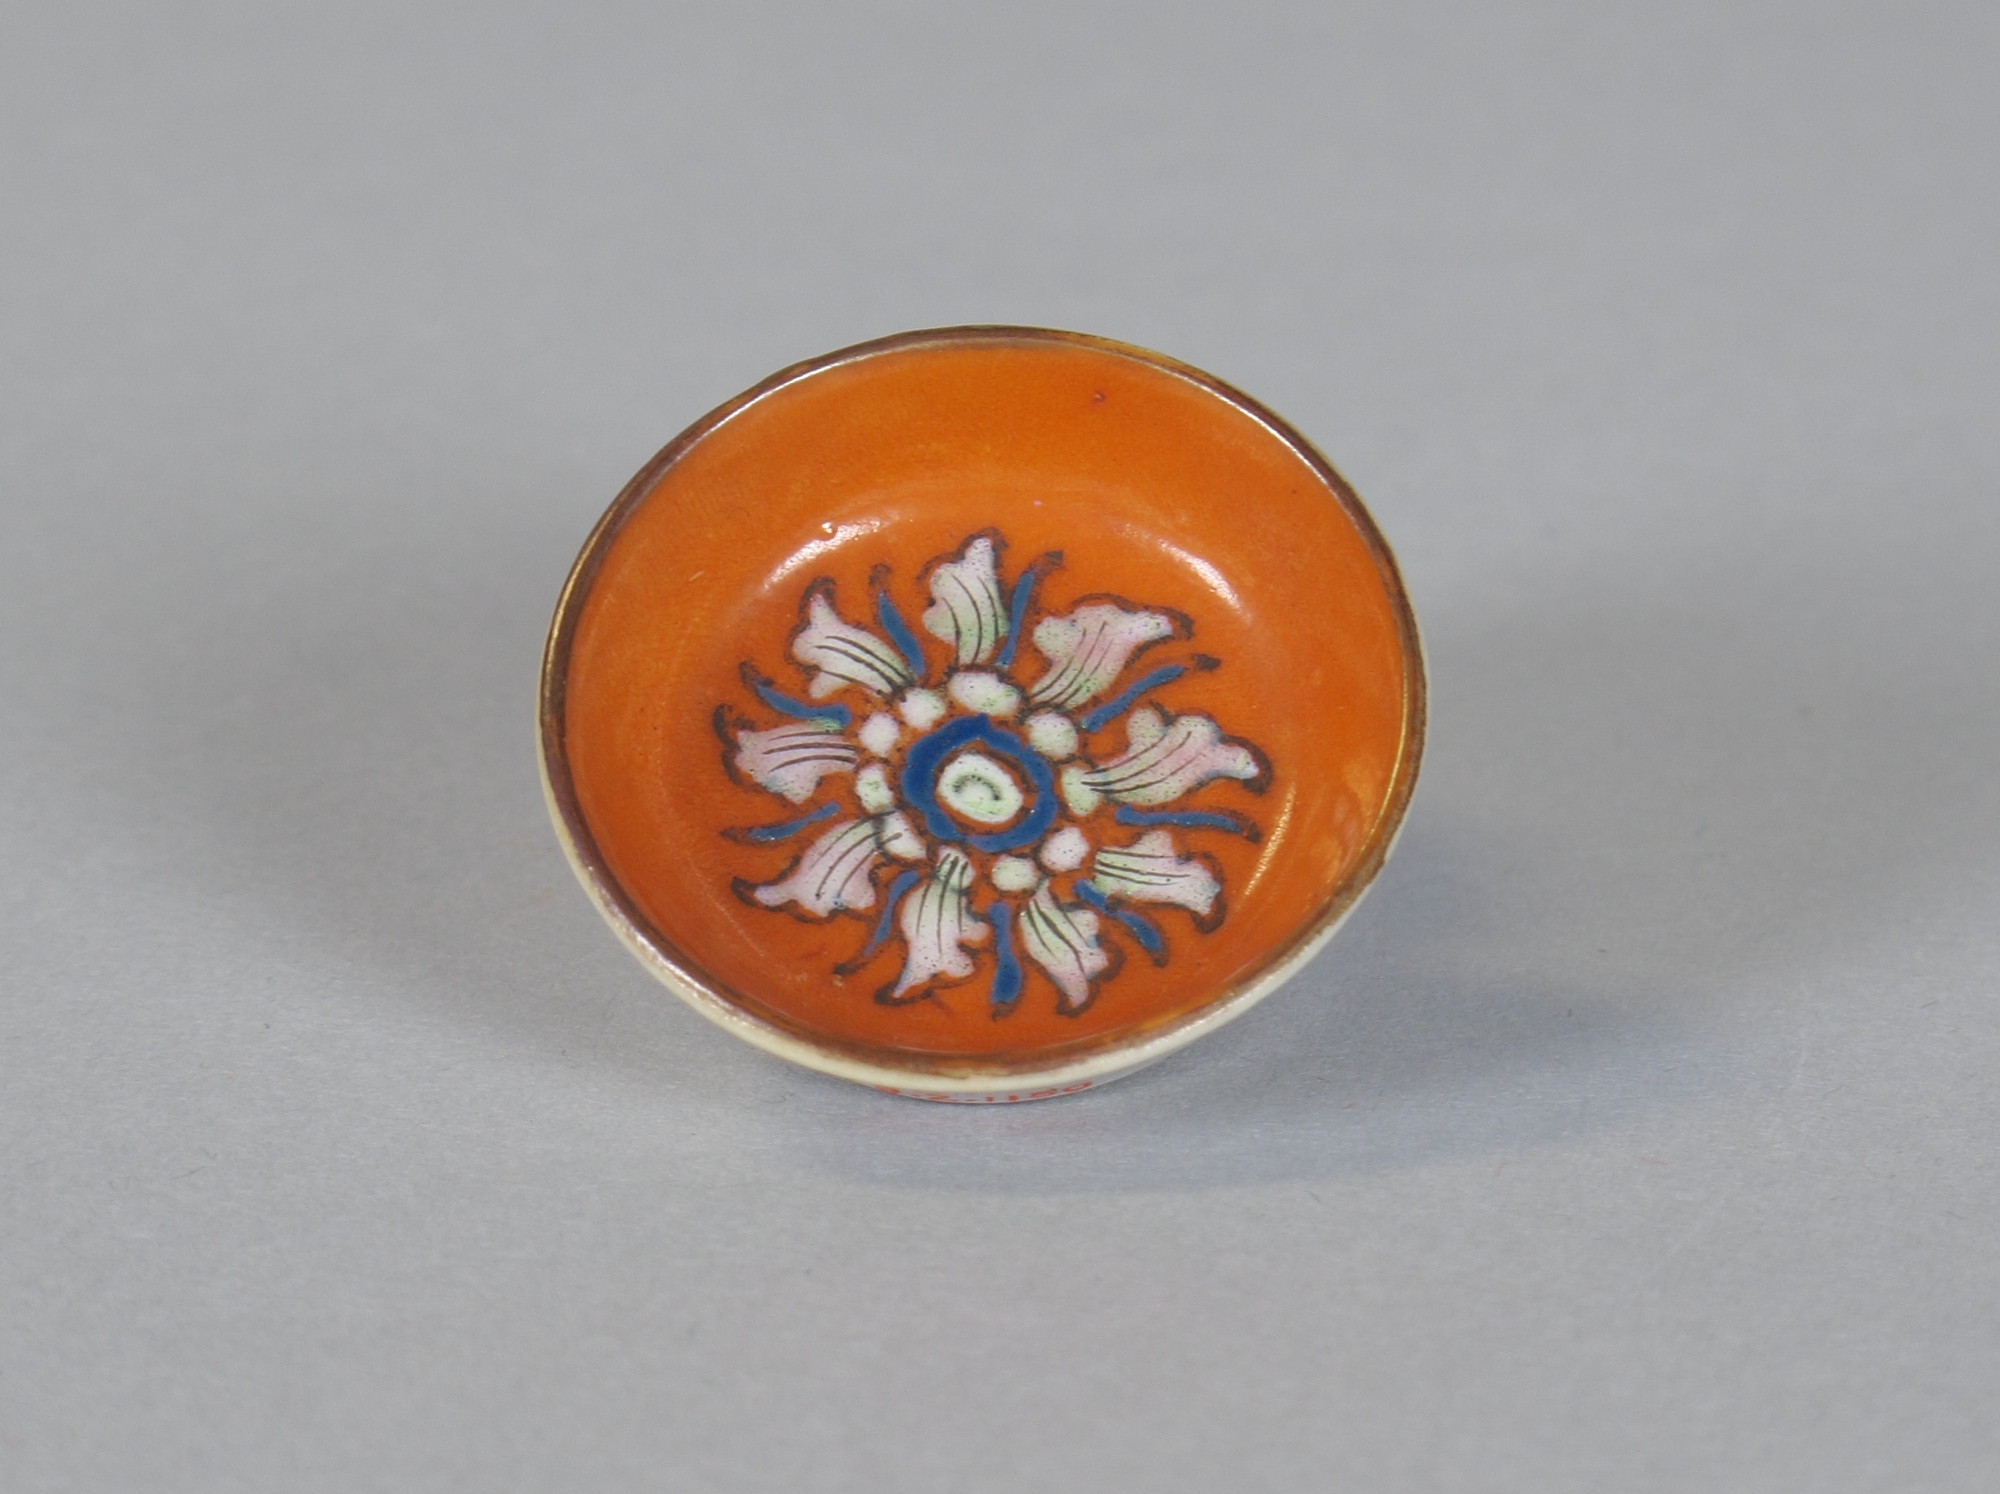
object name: cup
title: Cup (from a set of eight)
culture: chinese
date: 1644-1911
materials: enamel, glaze, iron, porcelain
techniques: overglaze, painting, polychrome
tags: flowers